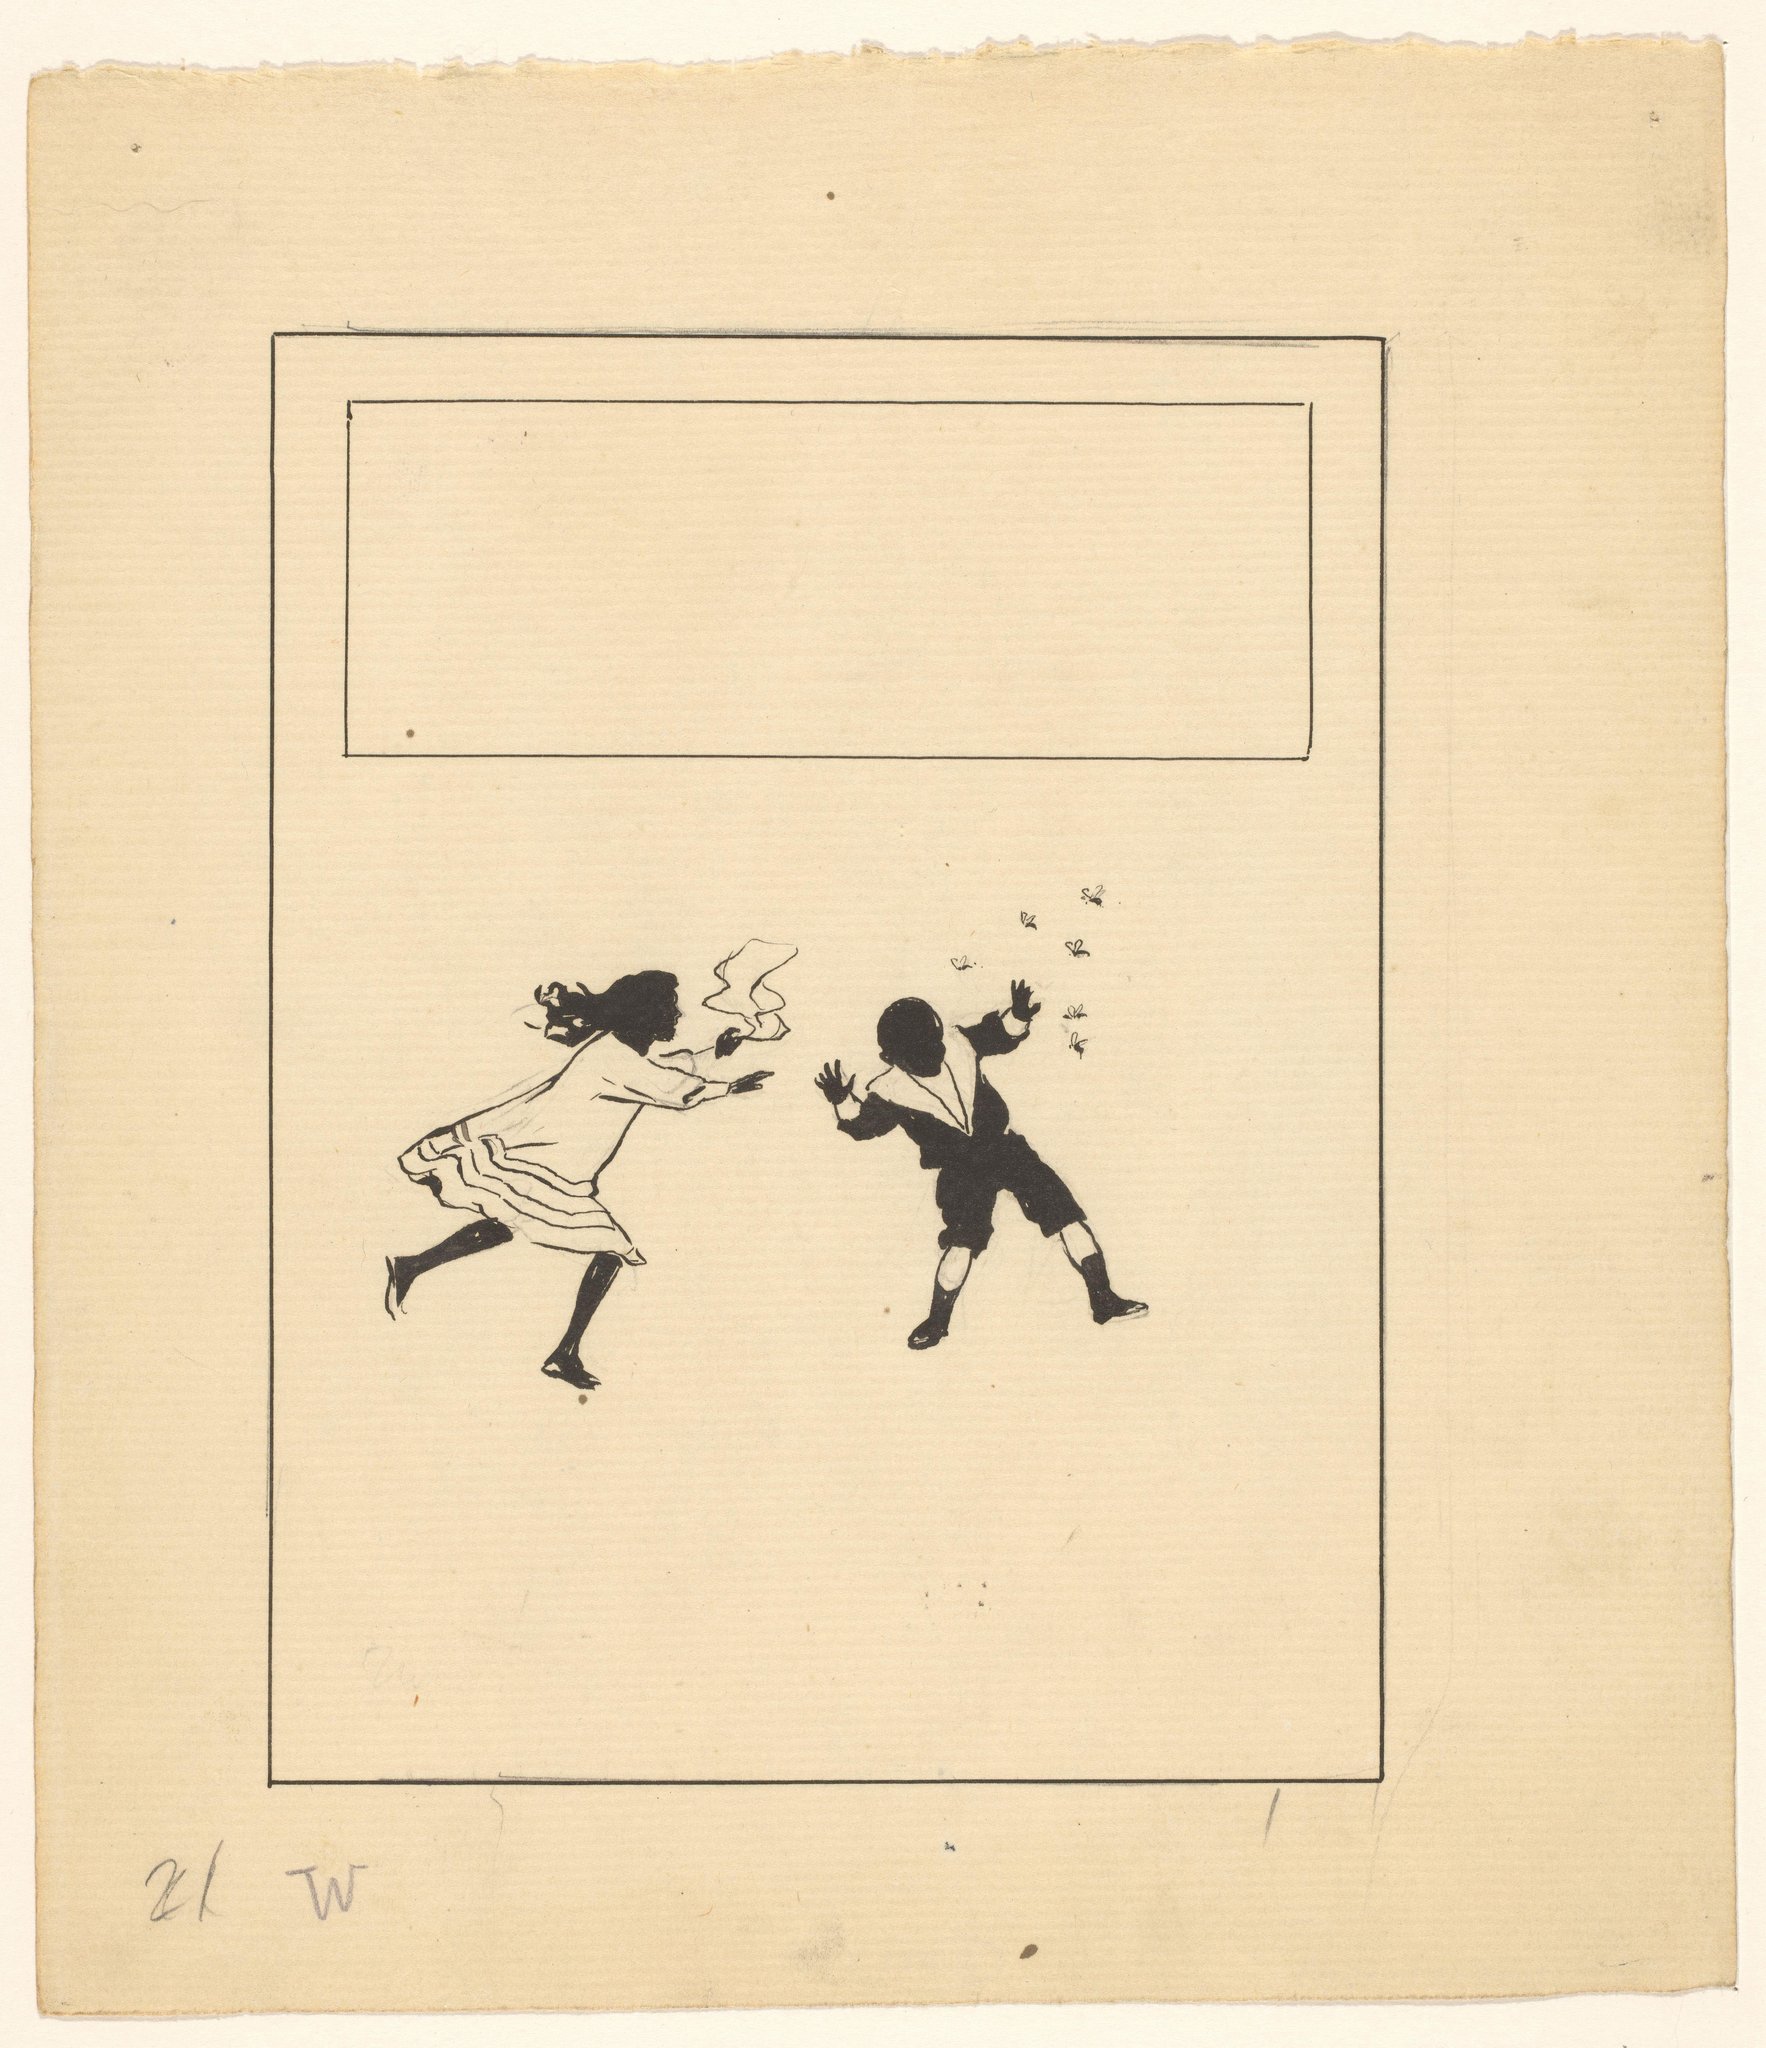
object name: drawing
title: Meisje jaagt wespen weg bij jongen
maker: Anonymous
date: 1880-1910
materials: ink, paper, pencil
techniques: brush, pen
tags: insects: wasp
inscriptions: collector's mark: Lugt 2228a, number: ‘21 W’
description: Zes wespen zwermen om een jongen heen. Een meisje komt aangerend met een doek om de wespen te verjagen.